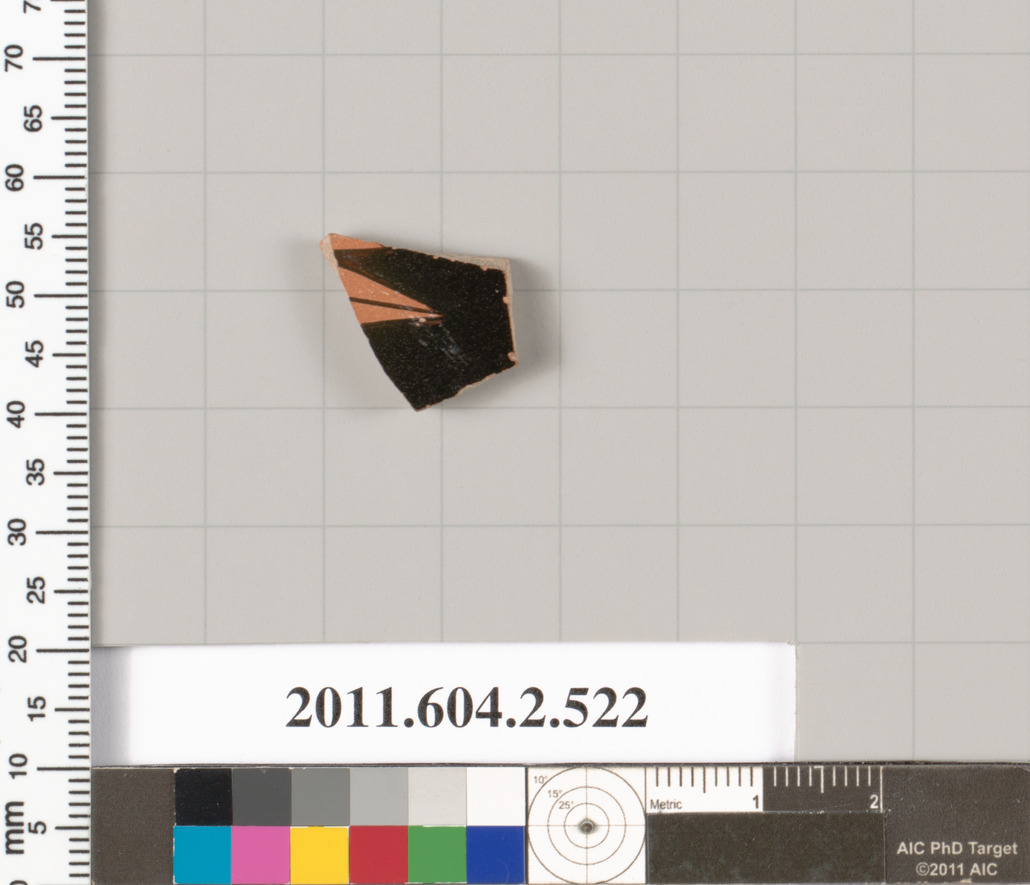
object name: column krater fragment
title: Terracotta fragment of a column-krater (bowl for mixing wine and water)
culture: greek, attic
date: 460-440 BCE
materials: terracotta